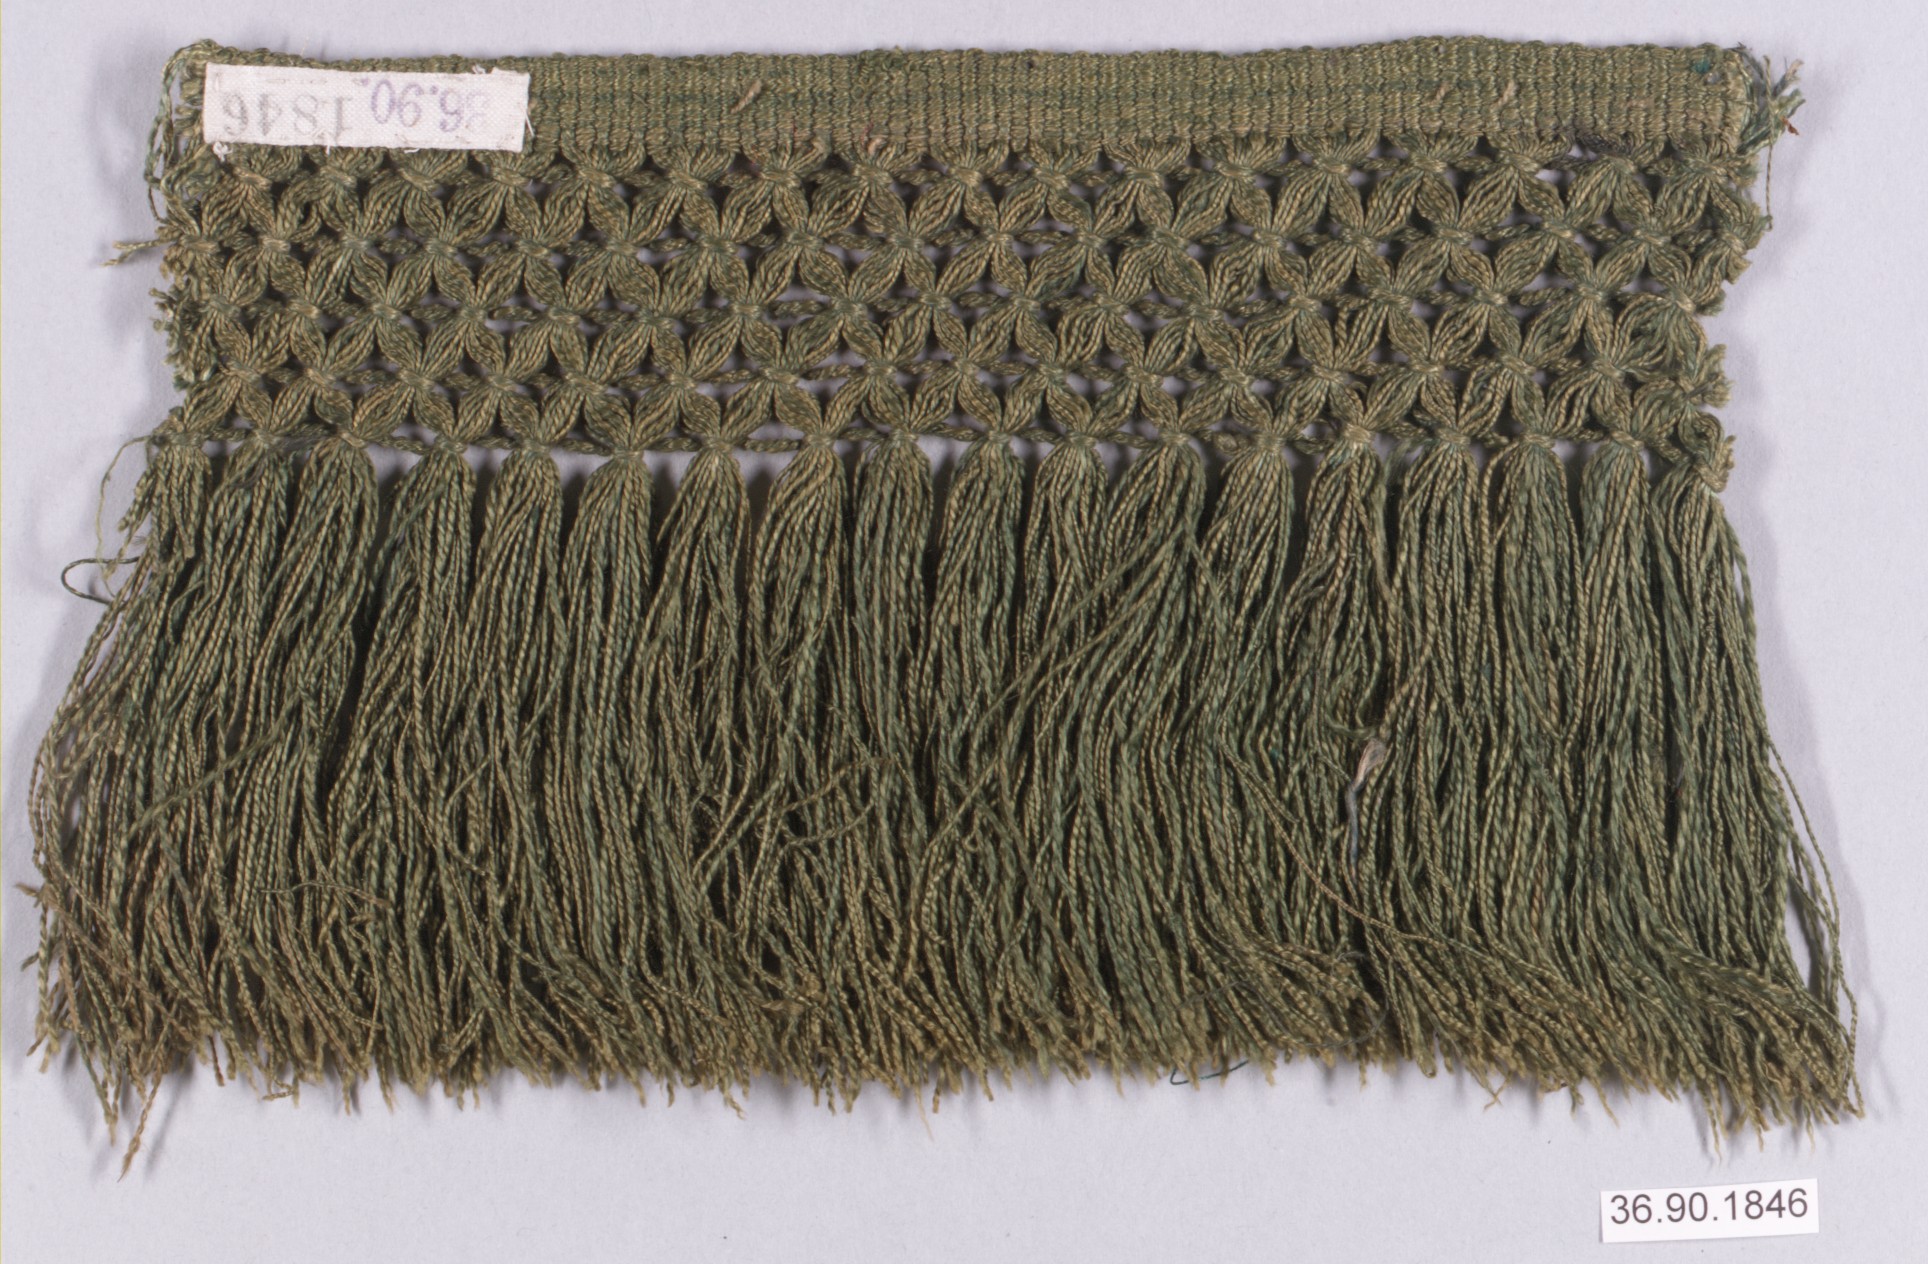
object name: fringe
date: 1801-1833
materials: silk